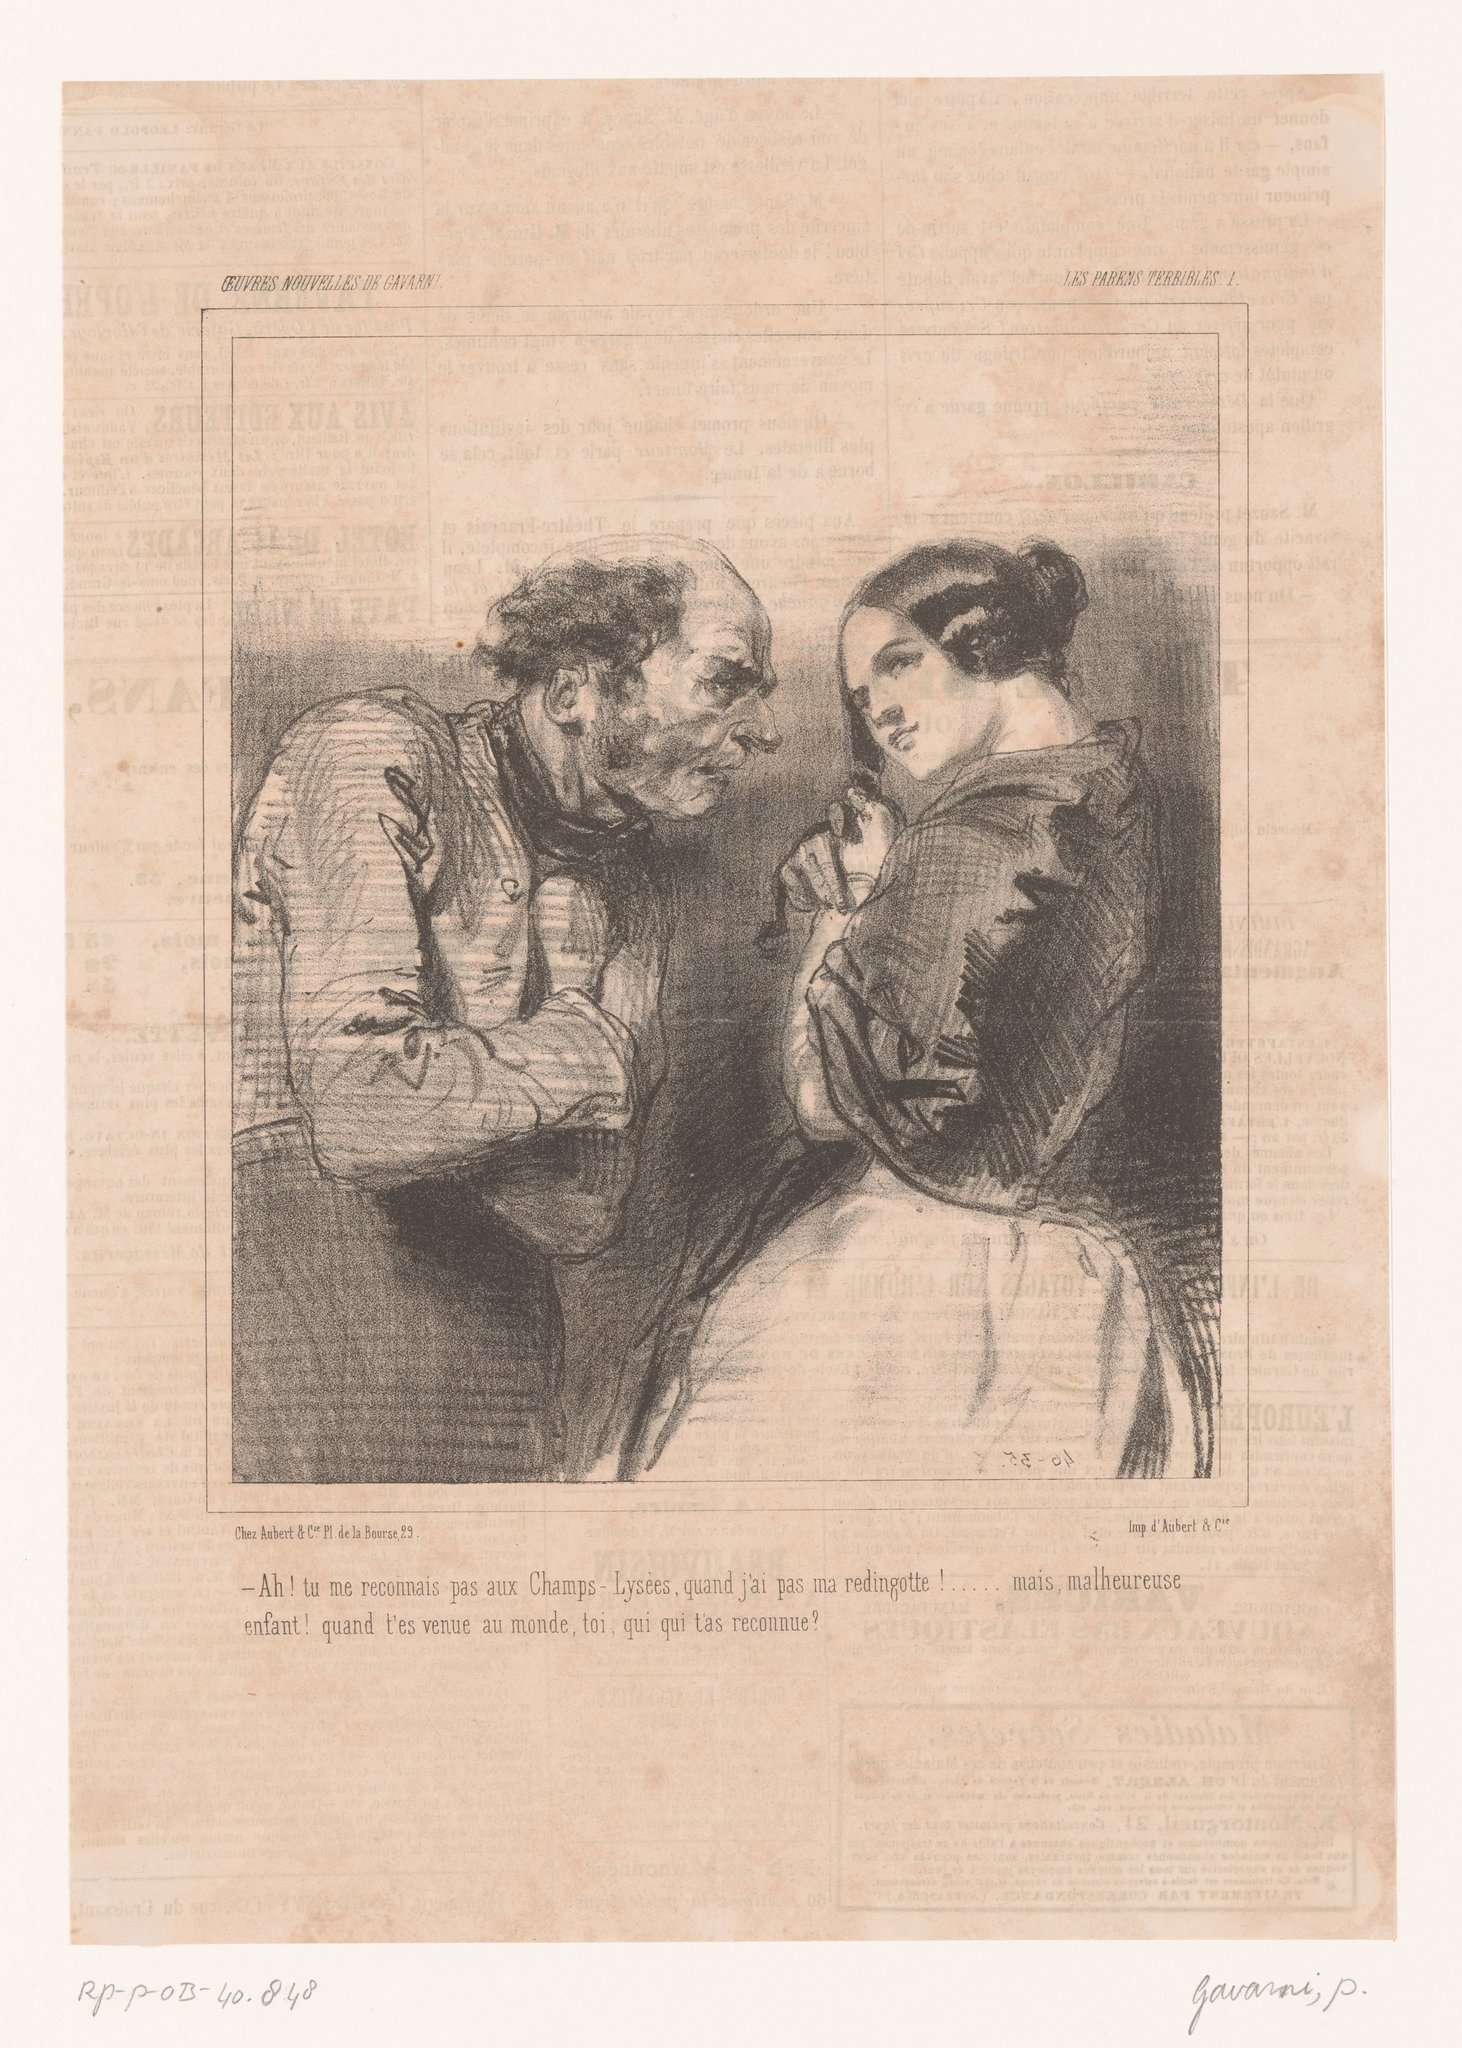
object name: cartoon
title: Ah! tu me reconnais pas aux Champs-Lysées (...)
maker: paul gavarni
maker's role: draughtsman, print maker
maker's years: 1804-1866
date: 1846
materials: paper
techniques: lithograph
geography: paris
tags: adolescent, young woman, maiden, grumbling, complaint; 'pianto', 'querela' (ripa), old man, father and daughter(s) (family group) (with number of daughters)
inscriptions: collector's mark: Lugt 2228a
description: De vader verwijt zijn dochter dat zij hem niet herkende op de Champs-Élysées.